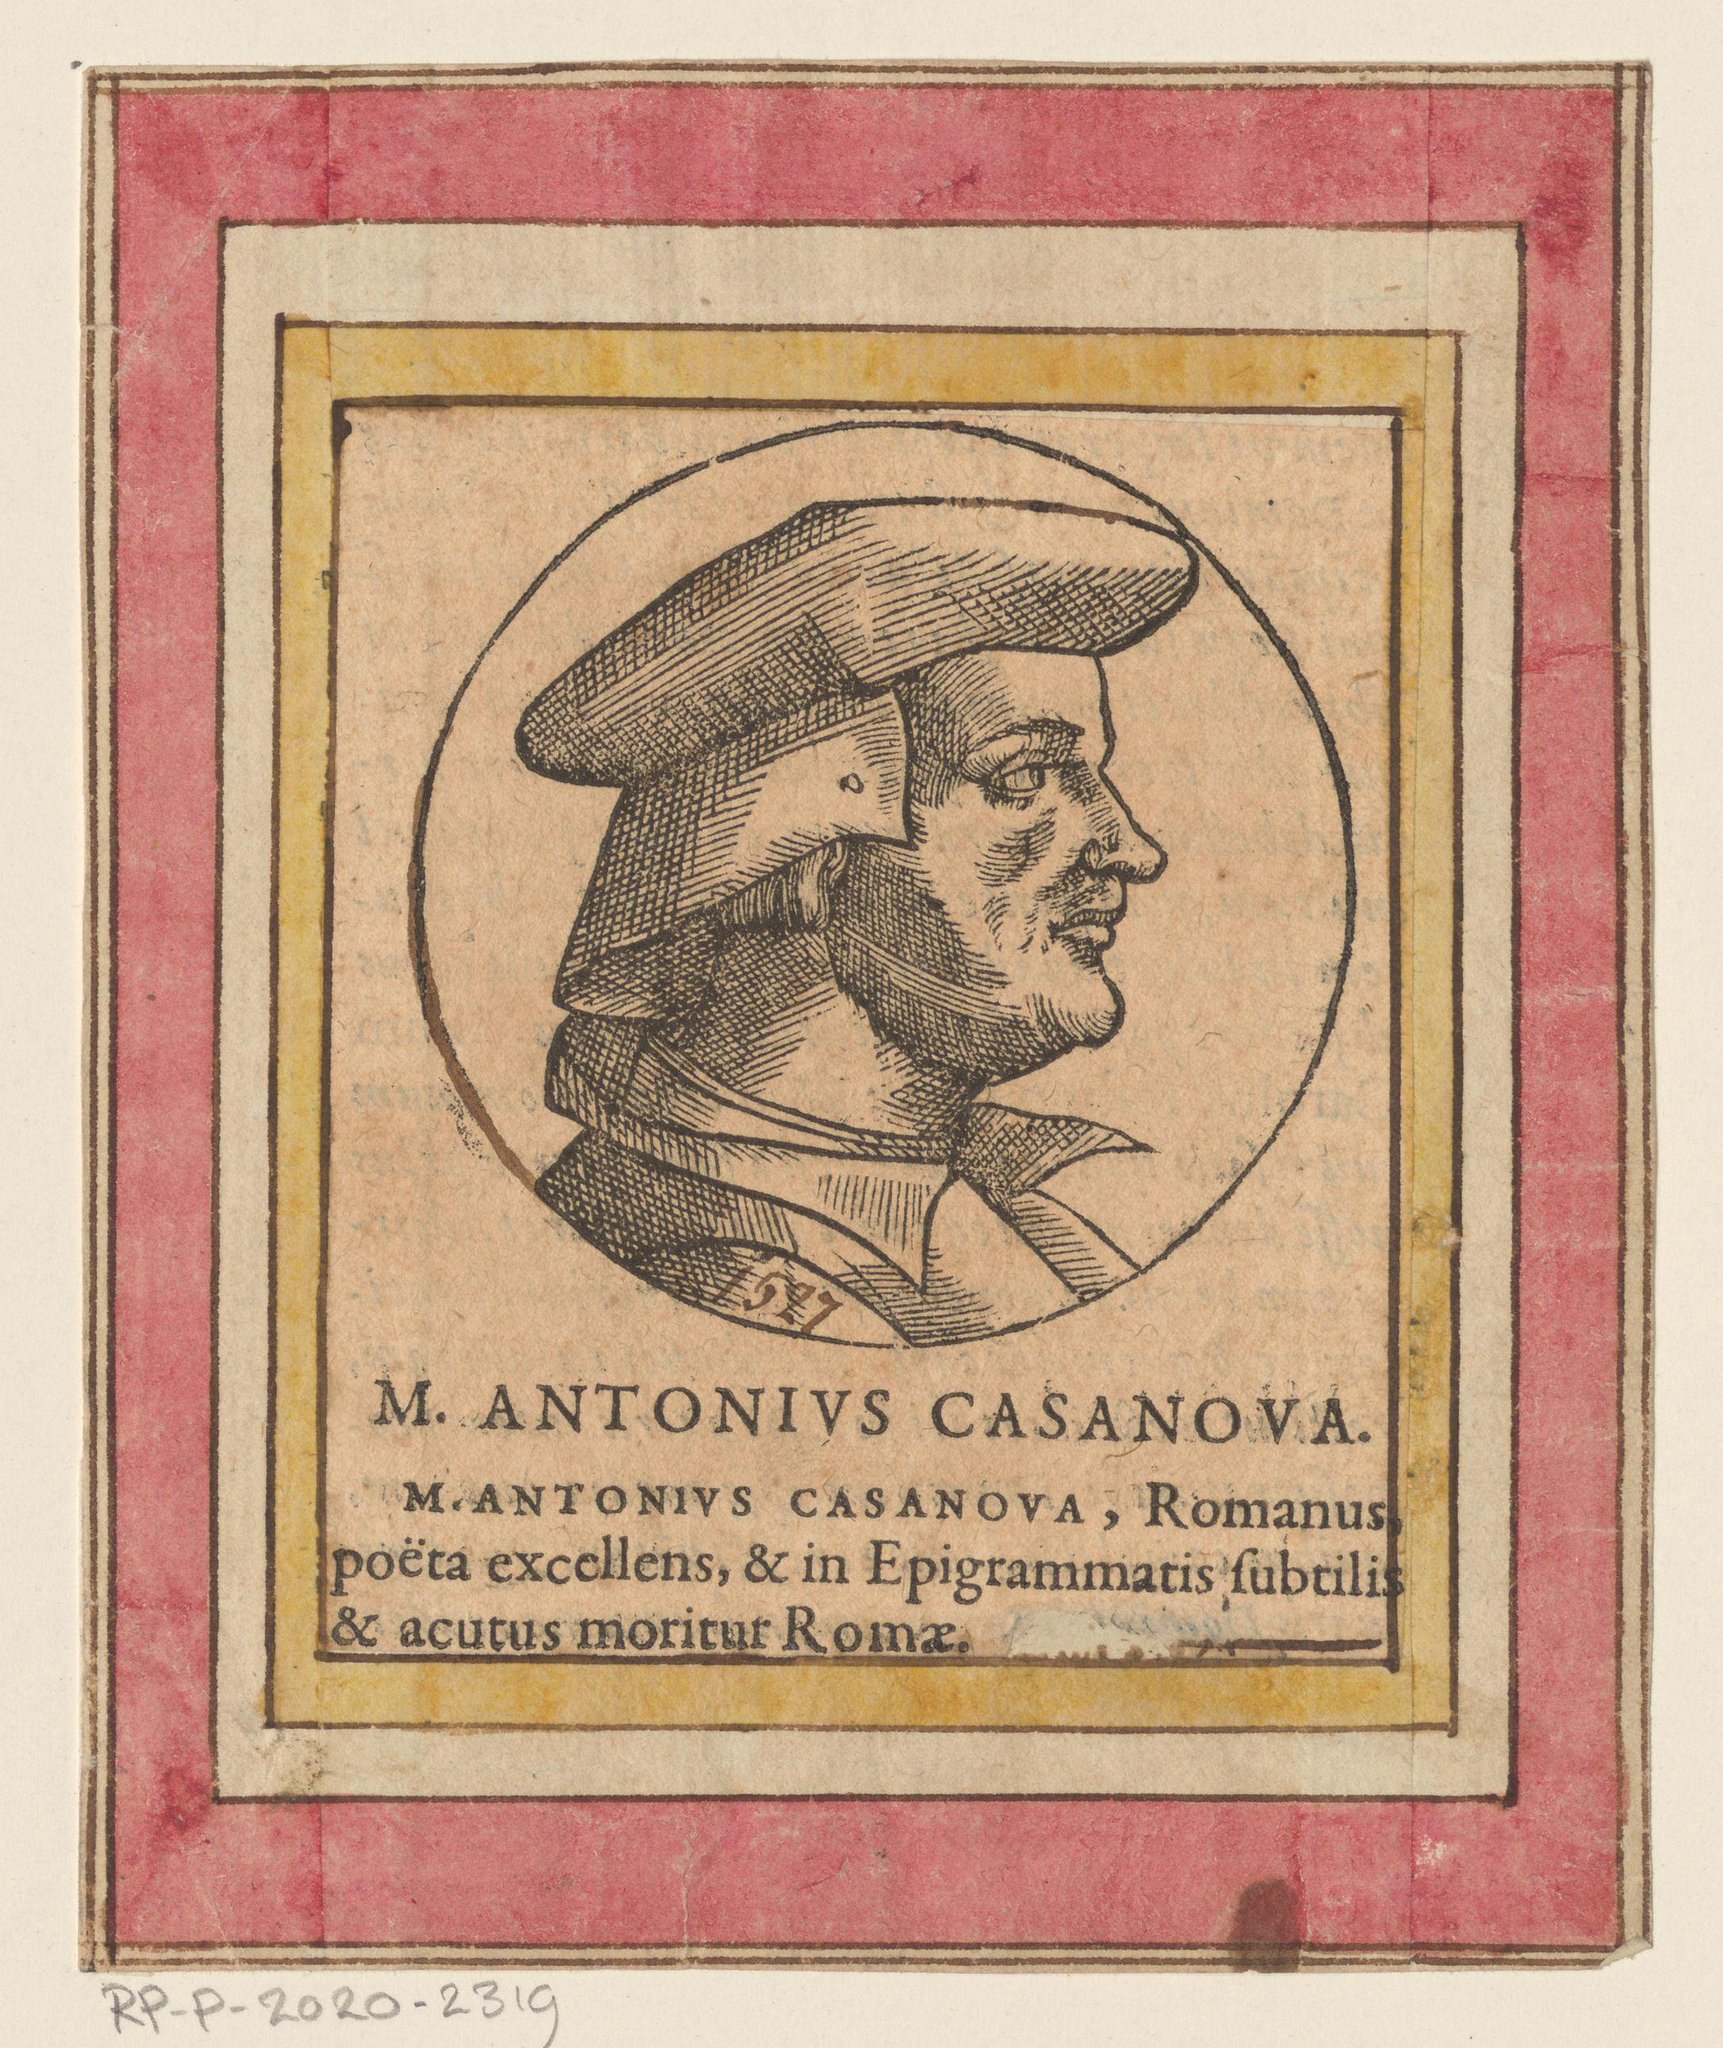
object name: print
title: Portret van Marcantonio Casanova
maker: Anonymous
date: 1625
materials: paper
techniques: hand coloring, letterpress printing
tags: historical persons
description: Prent mogelijk uit: Opmeer, Pieter van. Chronographia Petri Opmeeri (...). Keulen: Peter Henning, 1625. Of uit latere publicaties.